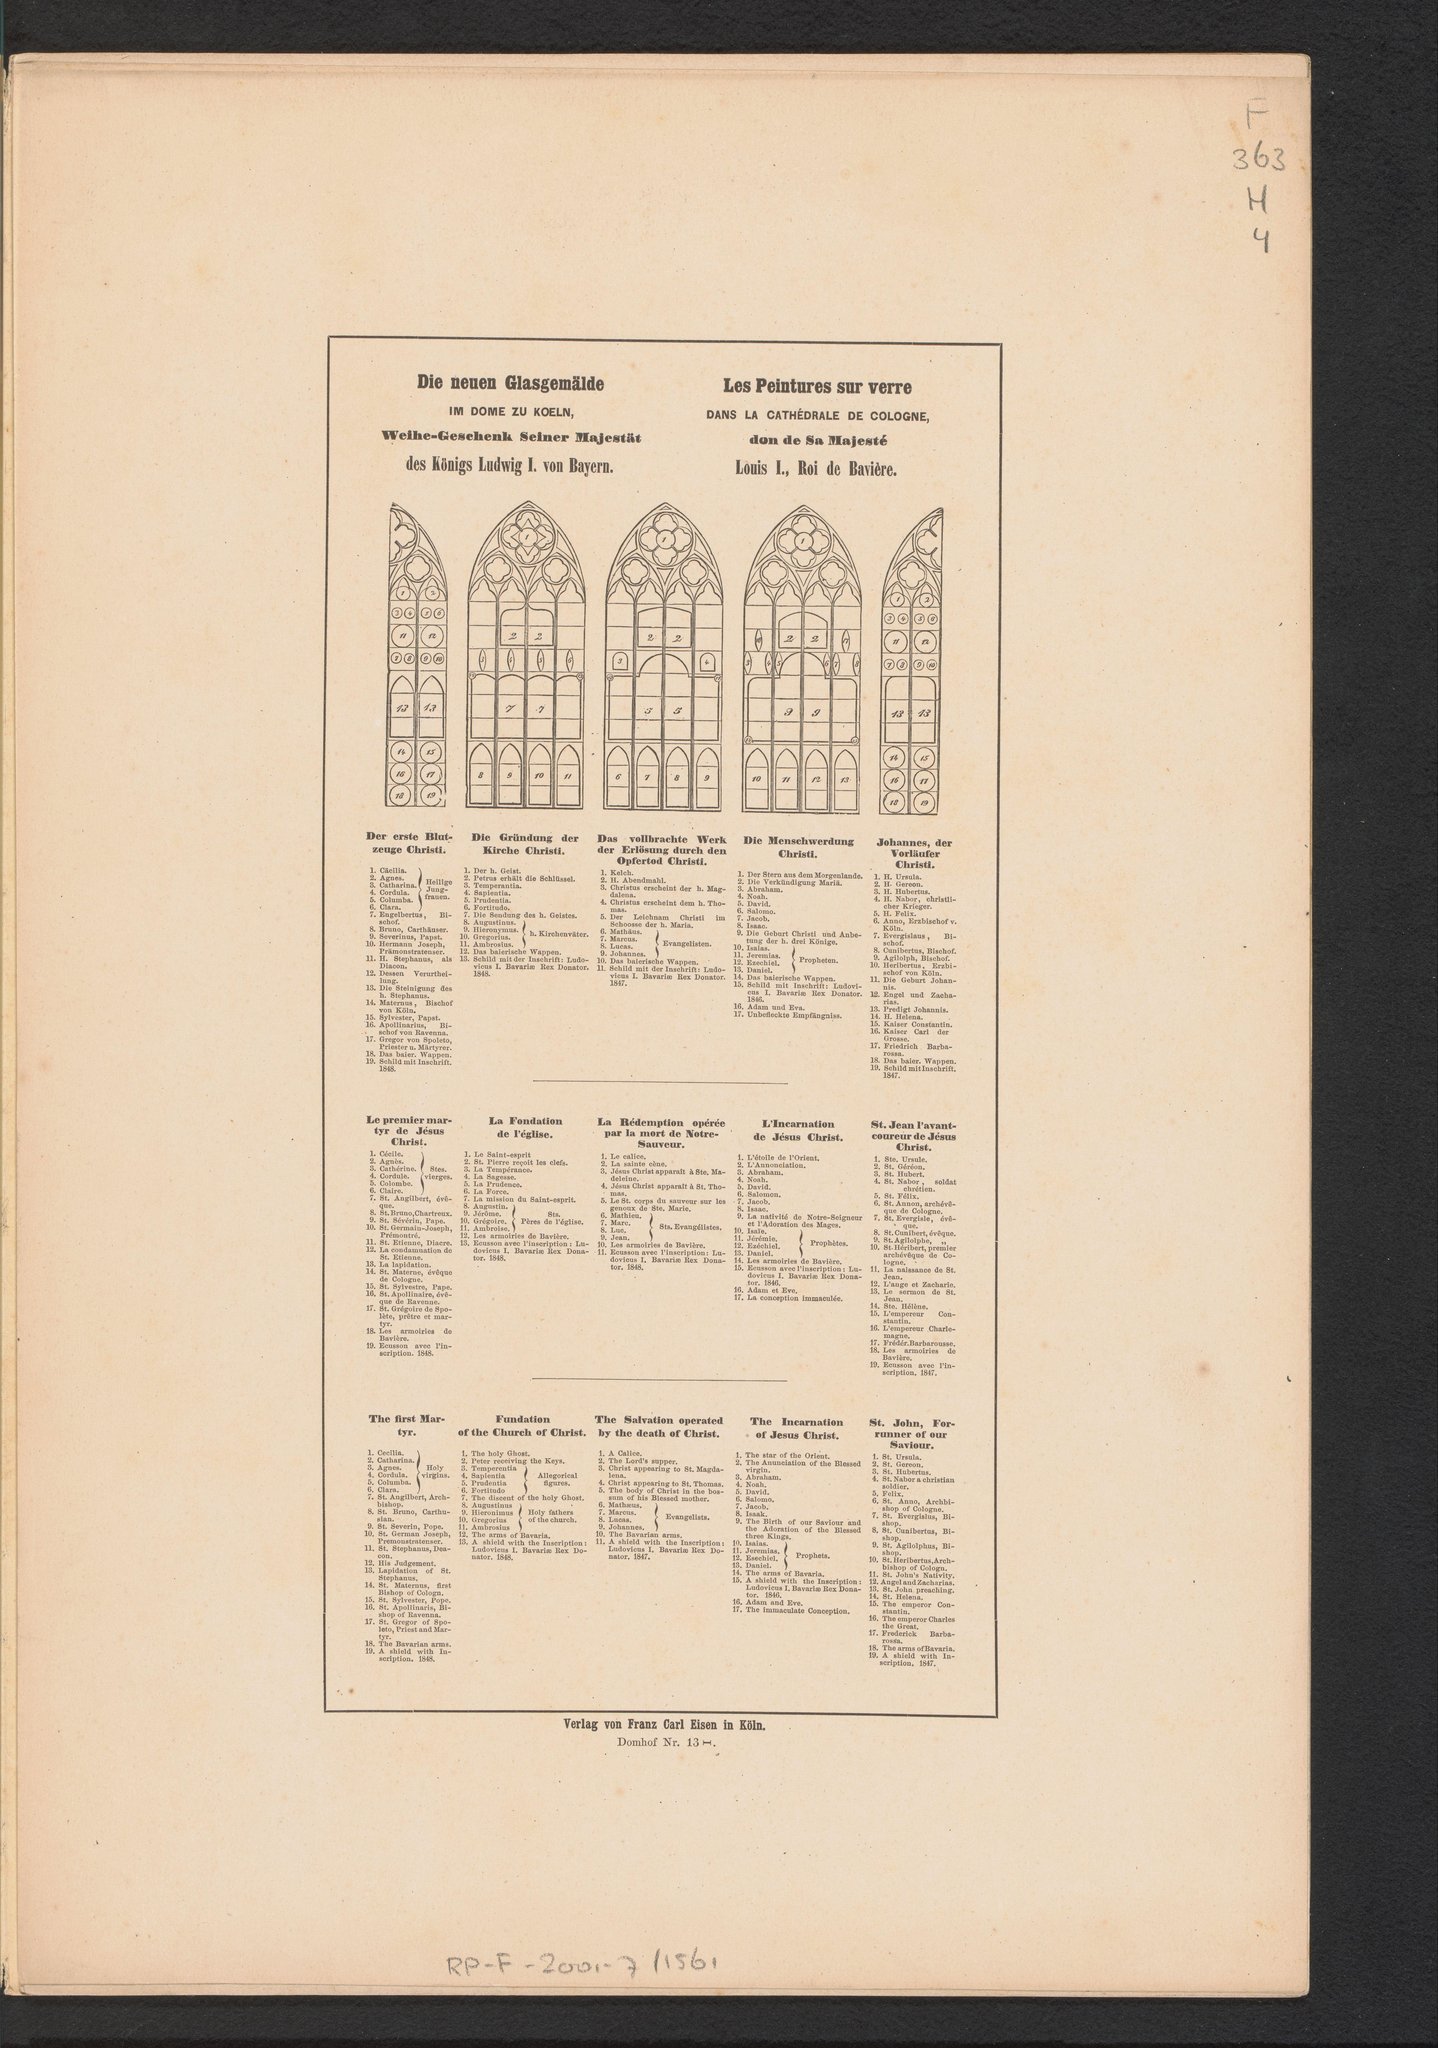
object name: wrapper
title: Die neuen Glasgemälde im Dome zu Köln, Weihegeschenk Seiner Majestät des Königs Ludwig I. von Bayern / Photographieen von Johann Franz Michiels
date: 1854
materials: cardboard, paper, photographic support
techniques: albumen print, printing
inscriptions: number: ‘K: I. II. 6./ M. 2. 6.’, retailer's mark: ‘GR[...]AT-[..]PFERSTICH-[K]ABINET’, annotation: ‘#9813/ HINL/ 9/98’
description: Omslag met vijf foto's en één tekstblad.